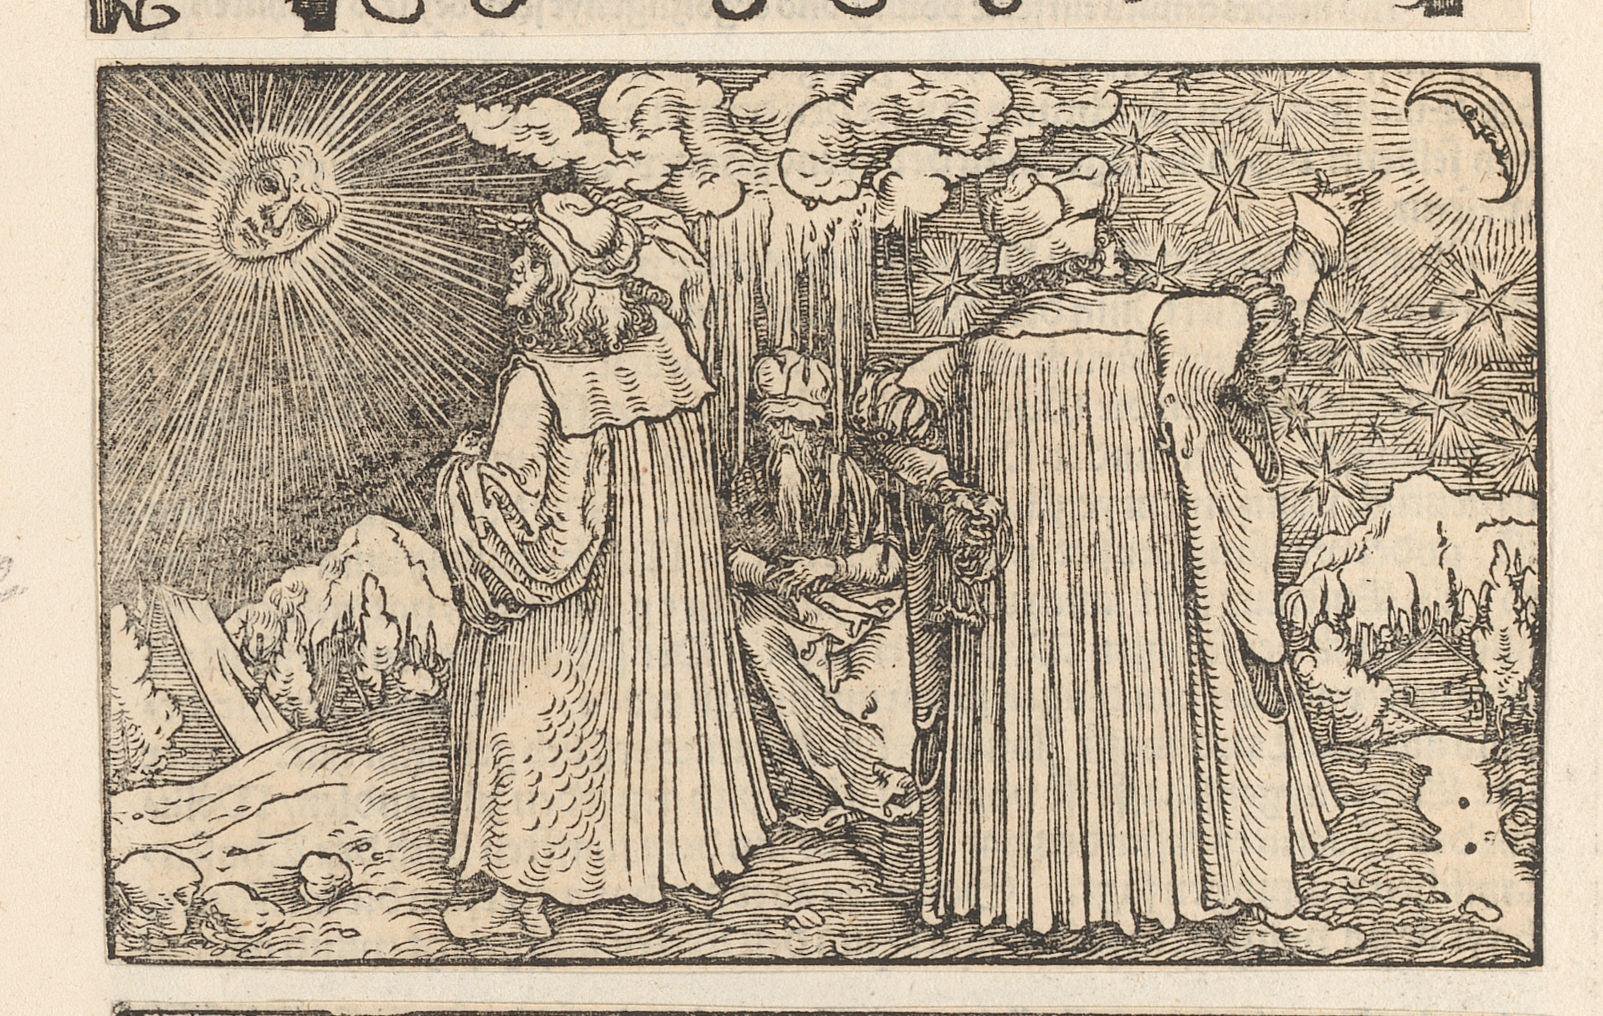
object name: book illustration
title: Twee mannen bestuderen de zon en de maan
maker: Anonymous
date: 1514-1532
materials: paper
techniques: letterpress printing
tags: contemplating the firmament, astrologer observing the heavens, contemplation of the moon, 'schwärmen', the heavens (celestial bodies)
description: Deze prent is gebruikt in: Petrarca, Francesco. Von der Artzney bayder Glück, des guten und widerwertigen: unnd weß sich ain yeder inn Gelück und Unglück halten sol (...). Augsburg: Heinrich Steiner, 1532. Deze uitgave is ook bekend onder de titel 'Trostspiegel in Glück und Unglück'.